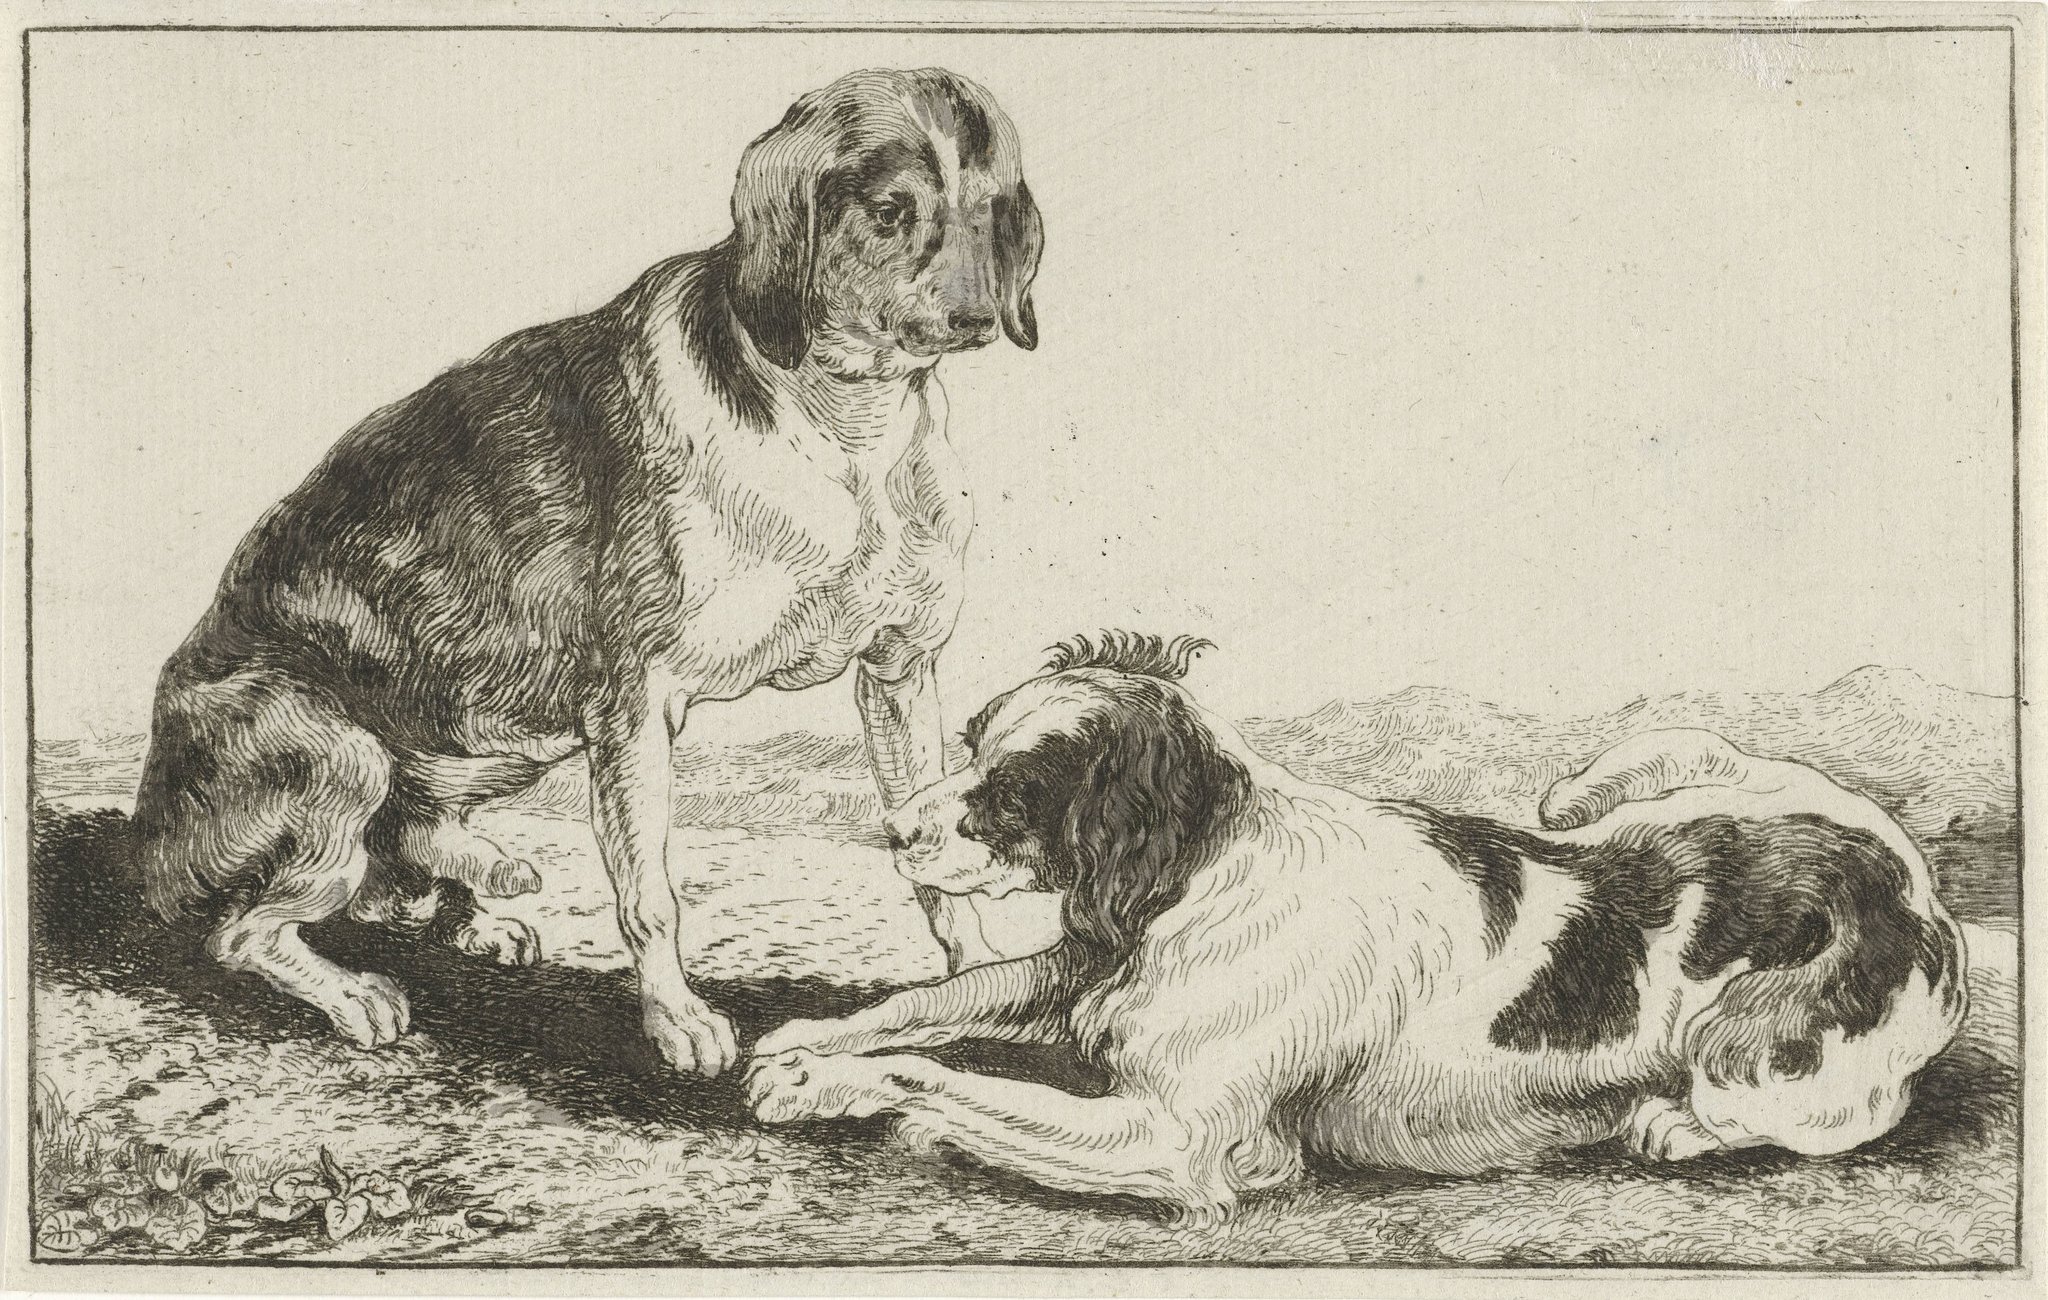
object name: print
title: Zoographiam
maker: jan van den hecke (i)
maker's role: print maker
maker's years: 1619-1684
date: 1656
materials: paper, pencil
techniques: brush, etching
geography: brussels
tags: dog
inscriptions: collector's mark: Lugt 2228, collector's mark: Lugt 1606, collector's mark: Lugt 2398, collector's mark: Lugt 913